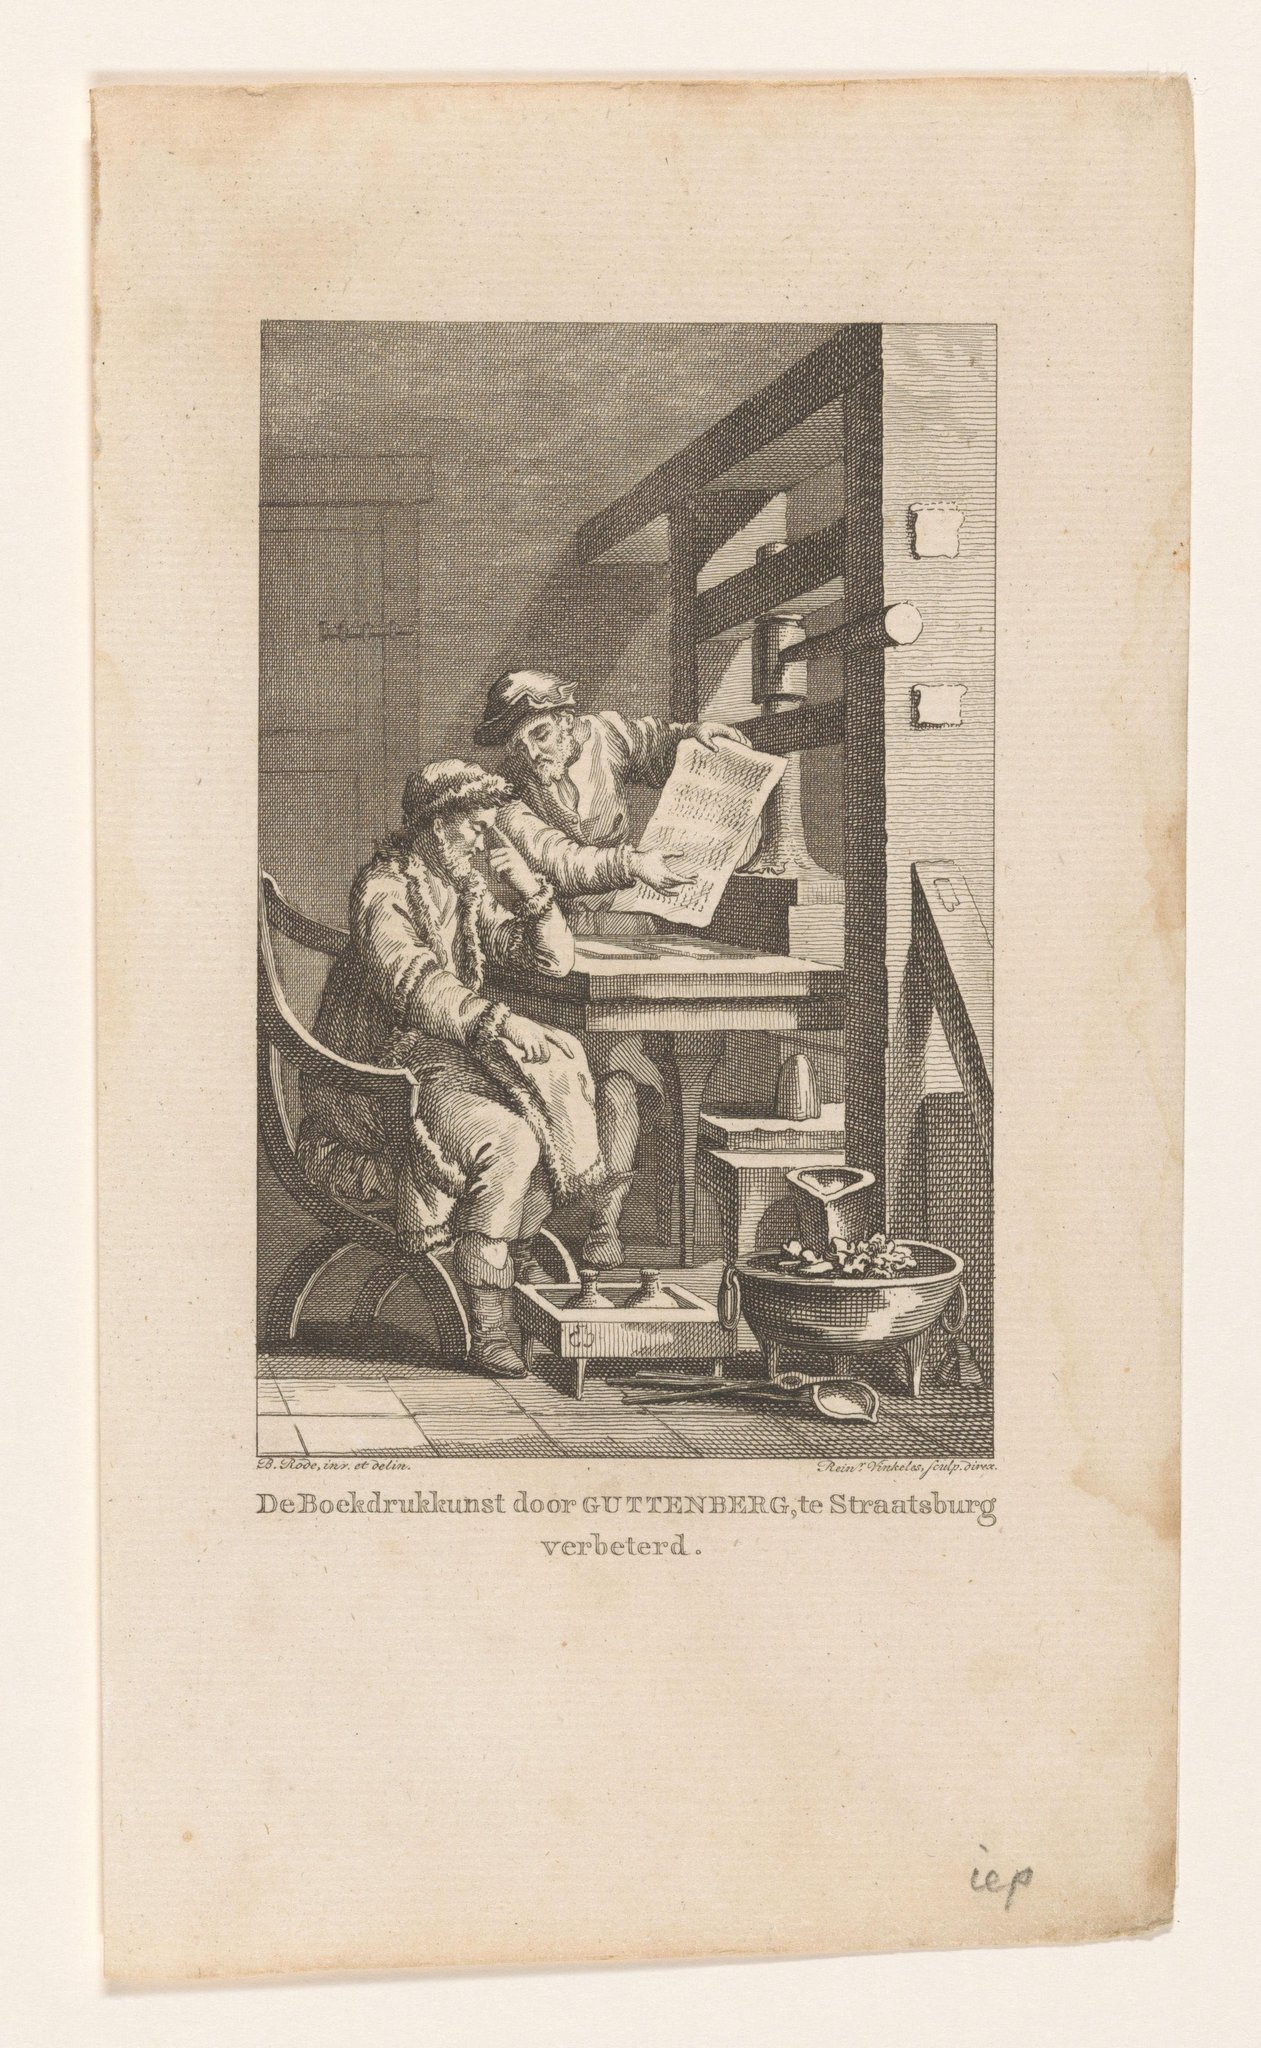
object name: print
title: De boekdrukkunst door Guttenberg, te Straatsburg verbeterd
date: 1751-1816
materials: paper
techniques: etching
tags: johannes gutenberg, printing press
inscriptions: collector's mark: Lugt 4779, collector's mark: Lugt 2228